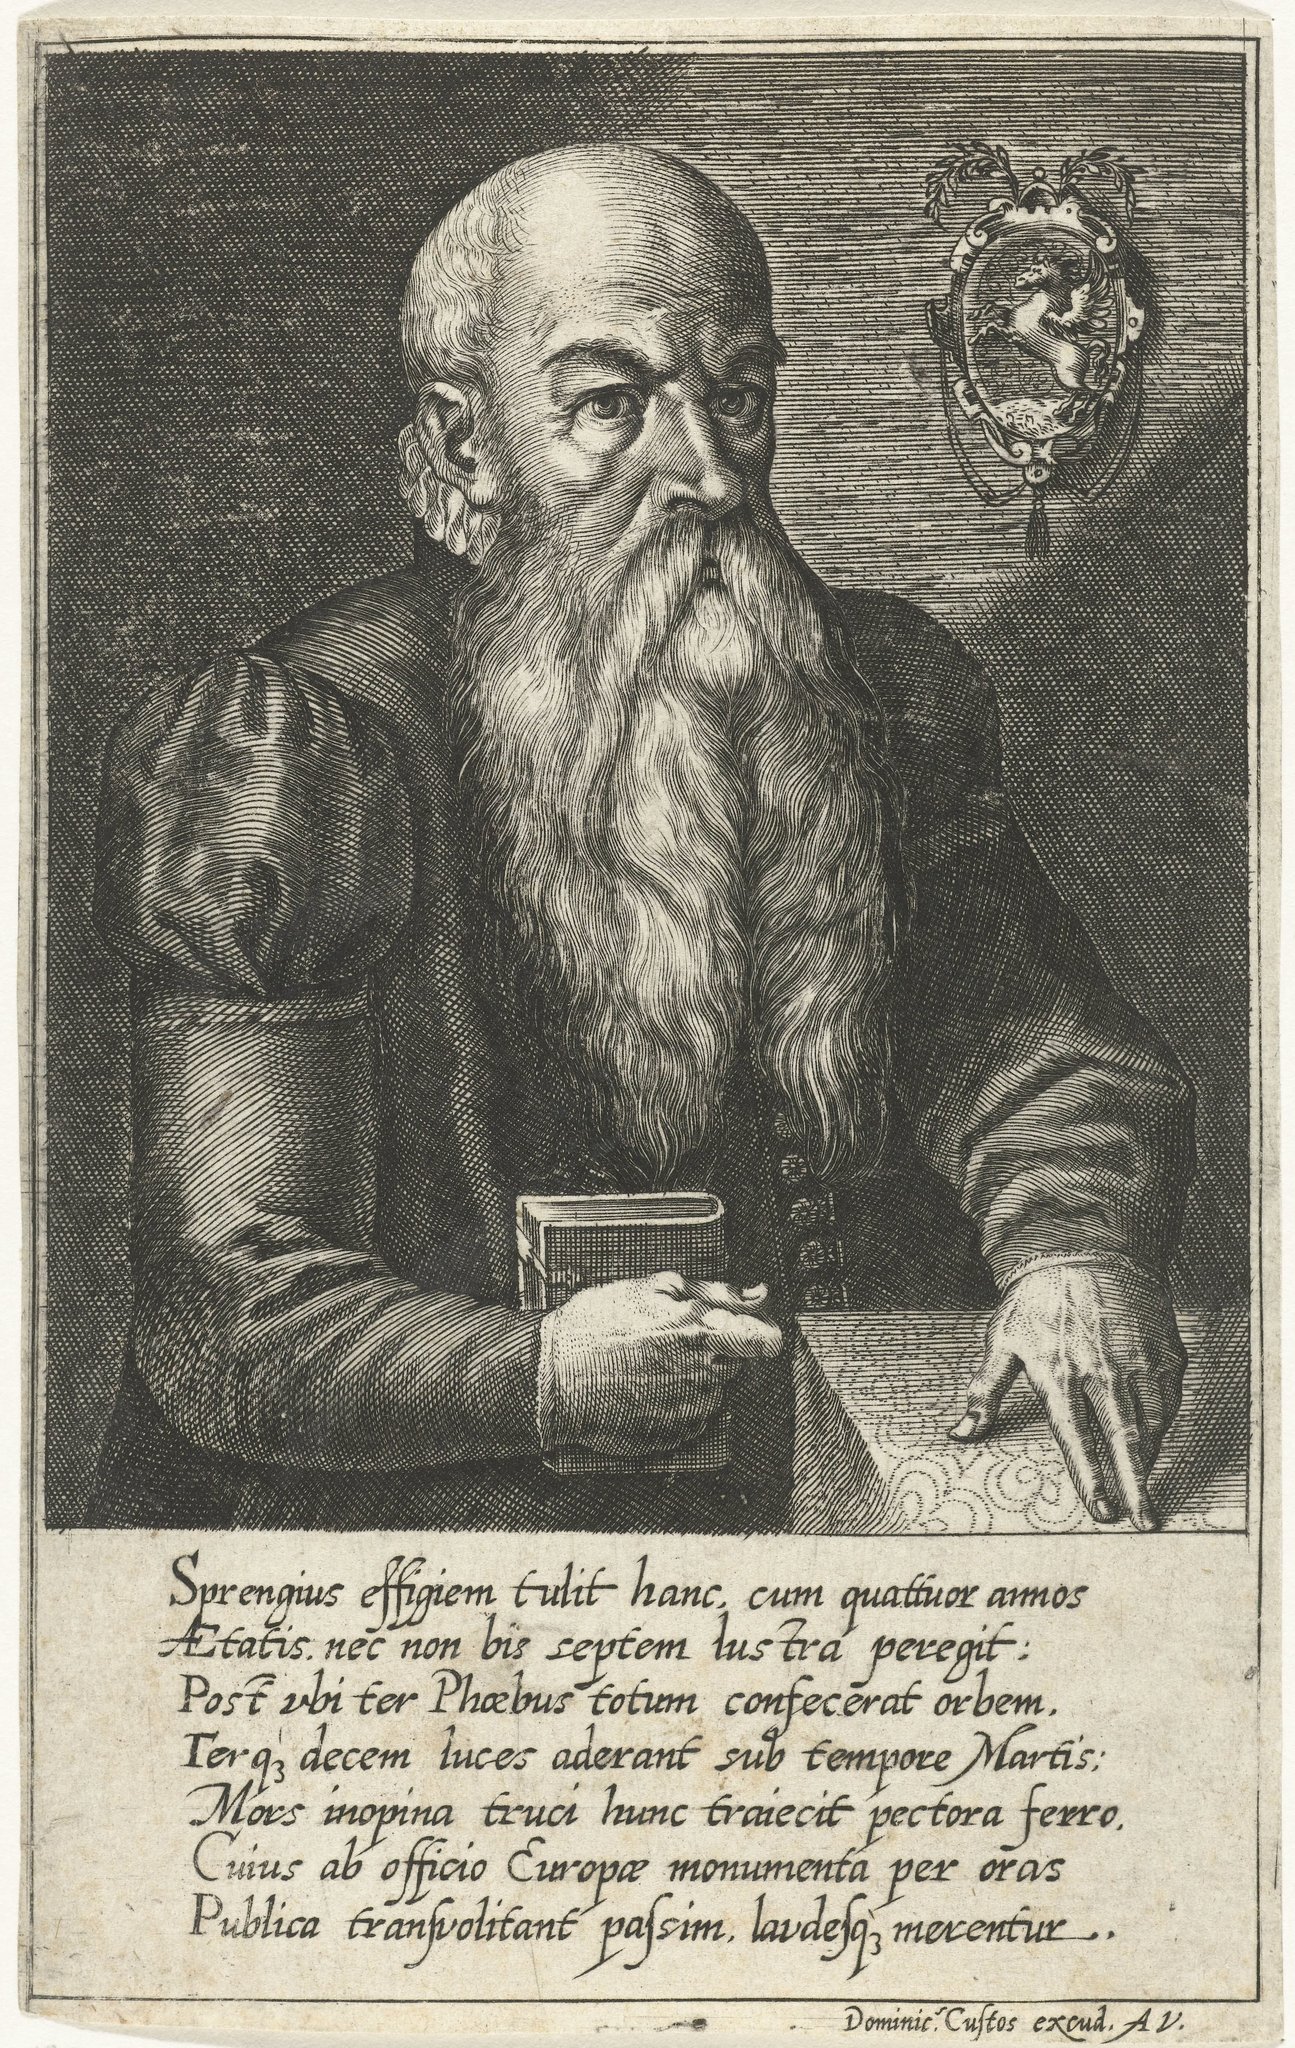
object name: print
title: Portret van de meesterzanger Johan Spreng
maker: dominicus custos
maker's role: print maker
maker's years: 1560-1615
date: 1579-1615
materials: paper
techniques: engraving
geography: augsburg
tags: notaris, vertaler, johan spreng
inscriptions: collector's mark: Lugt 2228